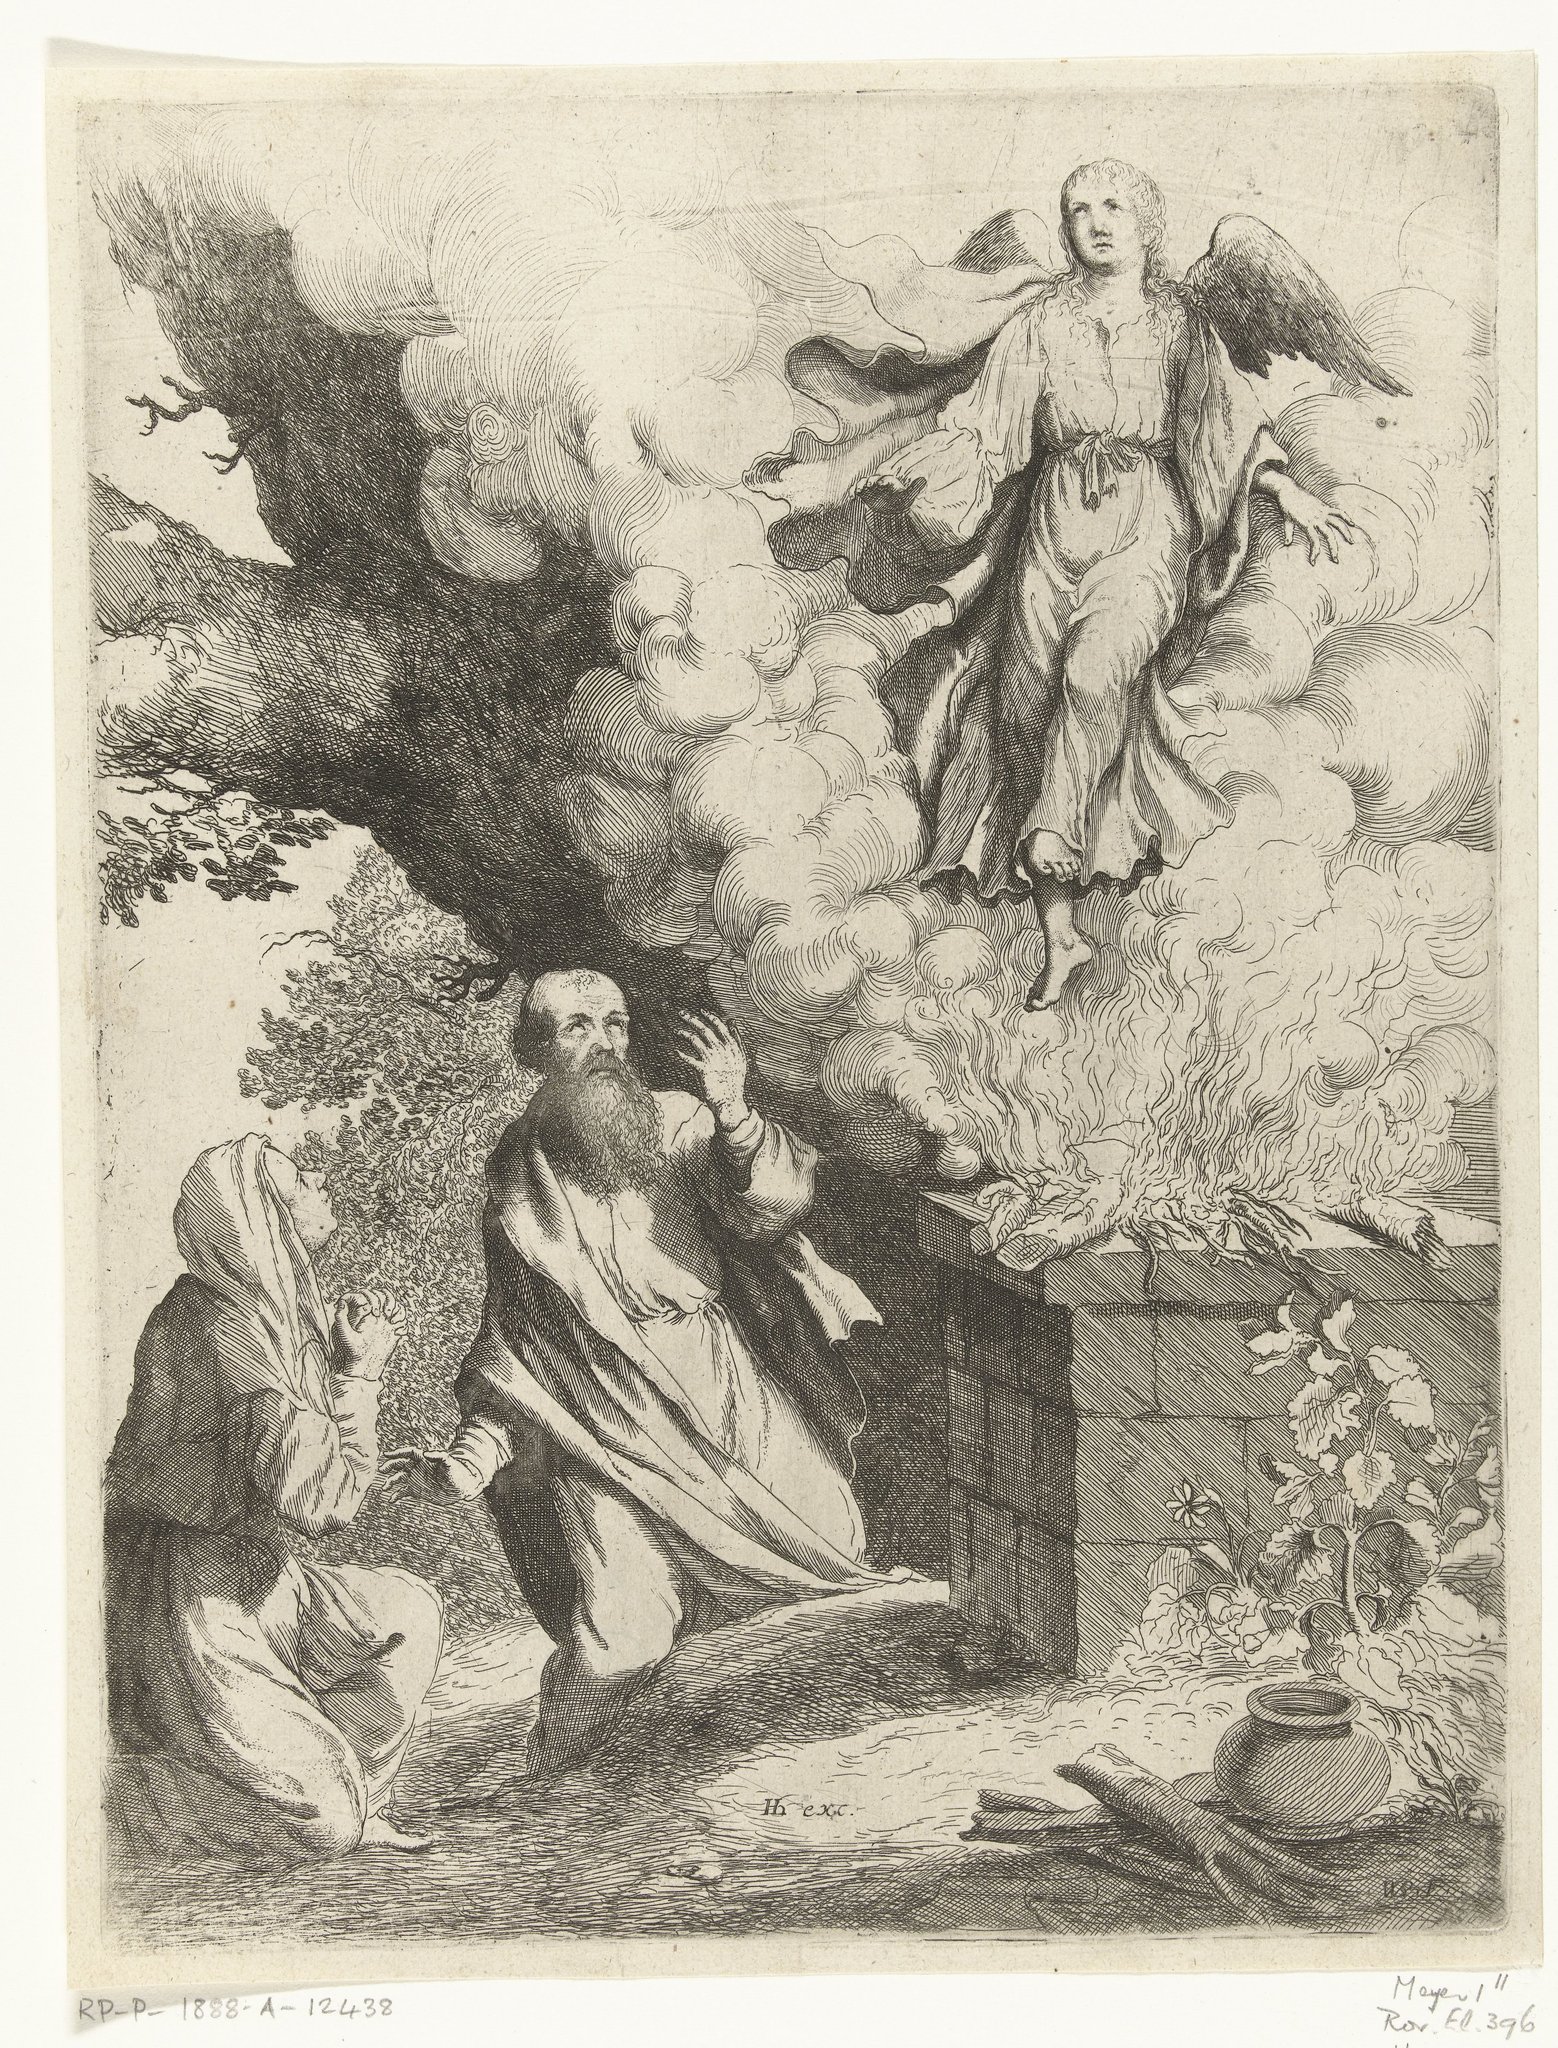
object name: print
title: Manoachs offer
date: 1633-1672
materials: paper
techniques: etching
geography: amsterdam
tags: manoah's sacrifice; the angel ascends in the flames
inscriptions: collector's mark: Lugt 2228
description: Manoach en zijn vrouw knielen op de grond terwijl de engel die hen de geboorte van Simon heeft voorspeld opstijgt naar de hemel in de rook van Manoachs offer.